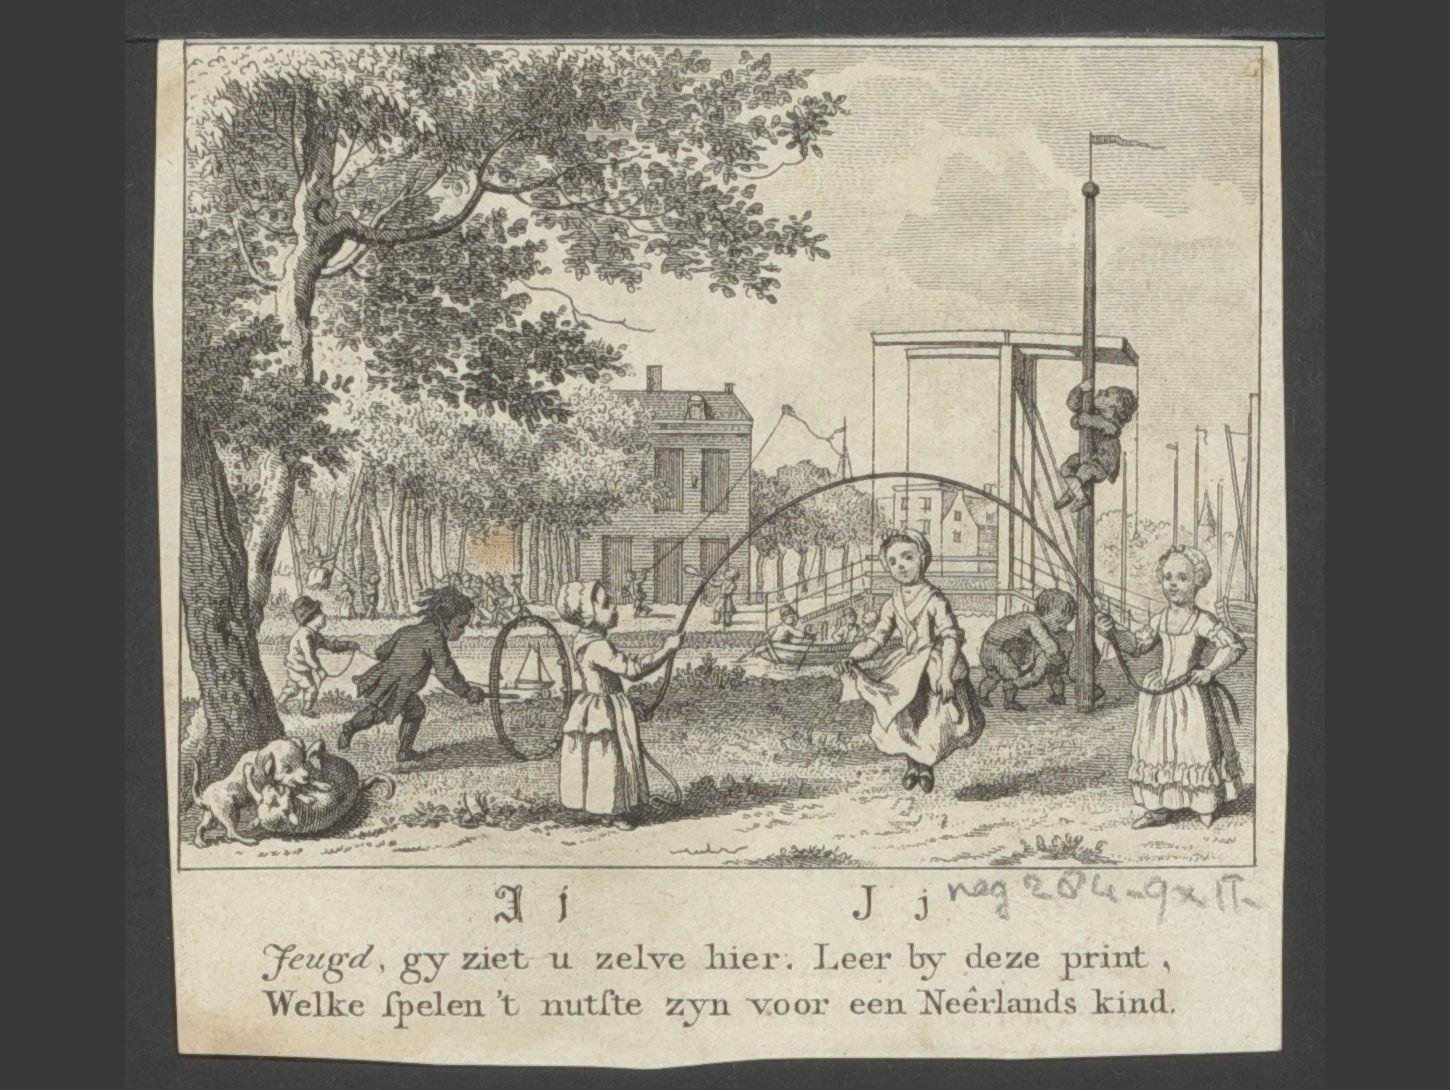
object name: book illustration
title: Spelende kinderen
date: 1781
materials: paper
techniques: engraving, etching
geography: amsterdam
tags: letters, alphabet, script, (bowling a) hoop, games using special objects (marbles, top, hoop, etc.)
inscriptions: stamp, collector's mark: Lugt 1641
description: Kinderen spelen in de buitenlucht. Op de voorgrond springen kinderen touw. Onder de voorstelling de letter J in twee verschillende lettertypes. Onderaan een tweeregelig vers over de jeugd. Onderwerpsrubrieken binnen de Atlas Zeden en Gewoonten: Onderwijs en Wetenschappen, Opvoeding en Onderwijs, Haneboeken en schoolprenten.